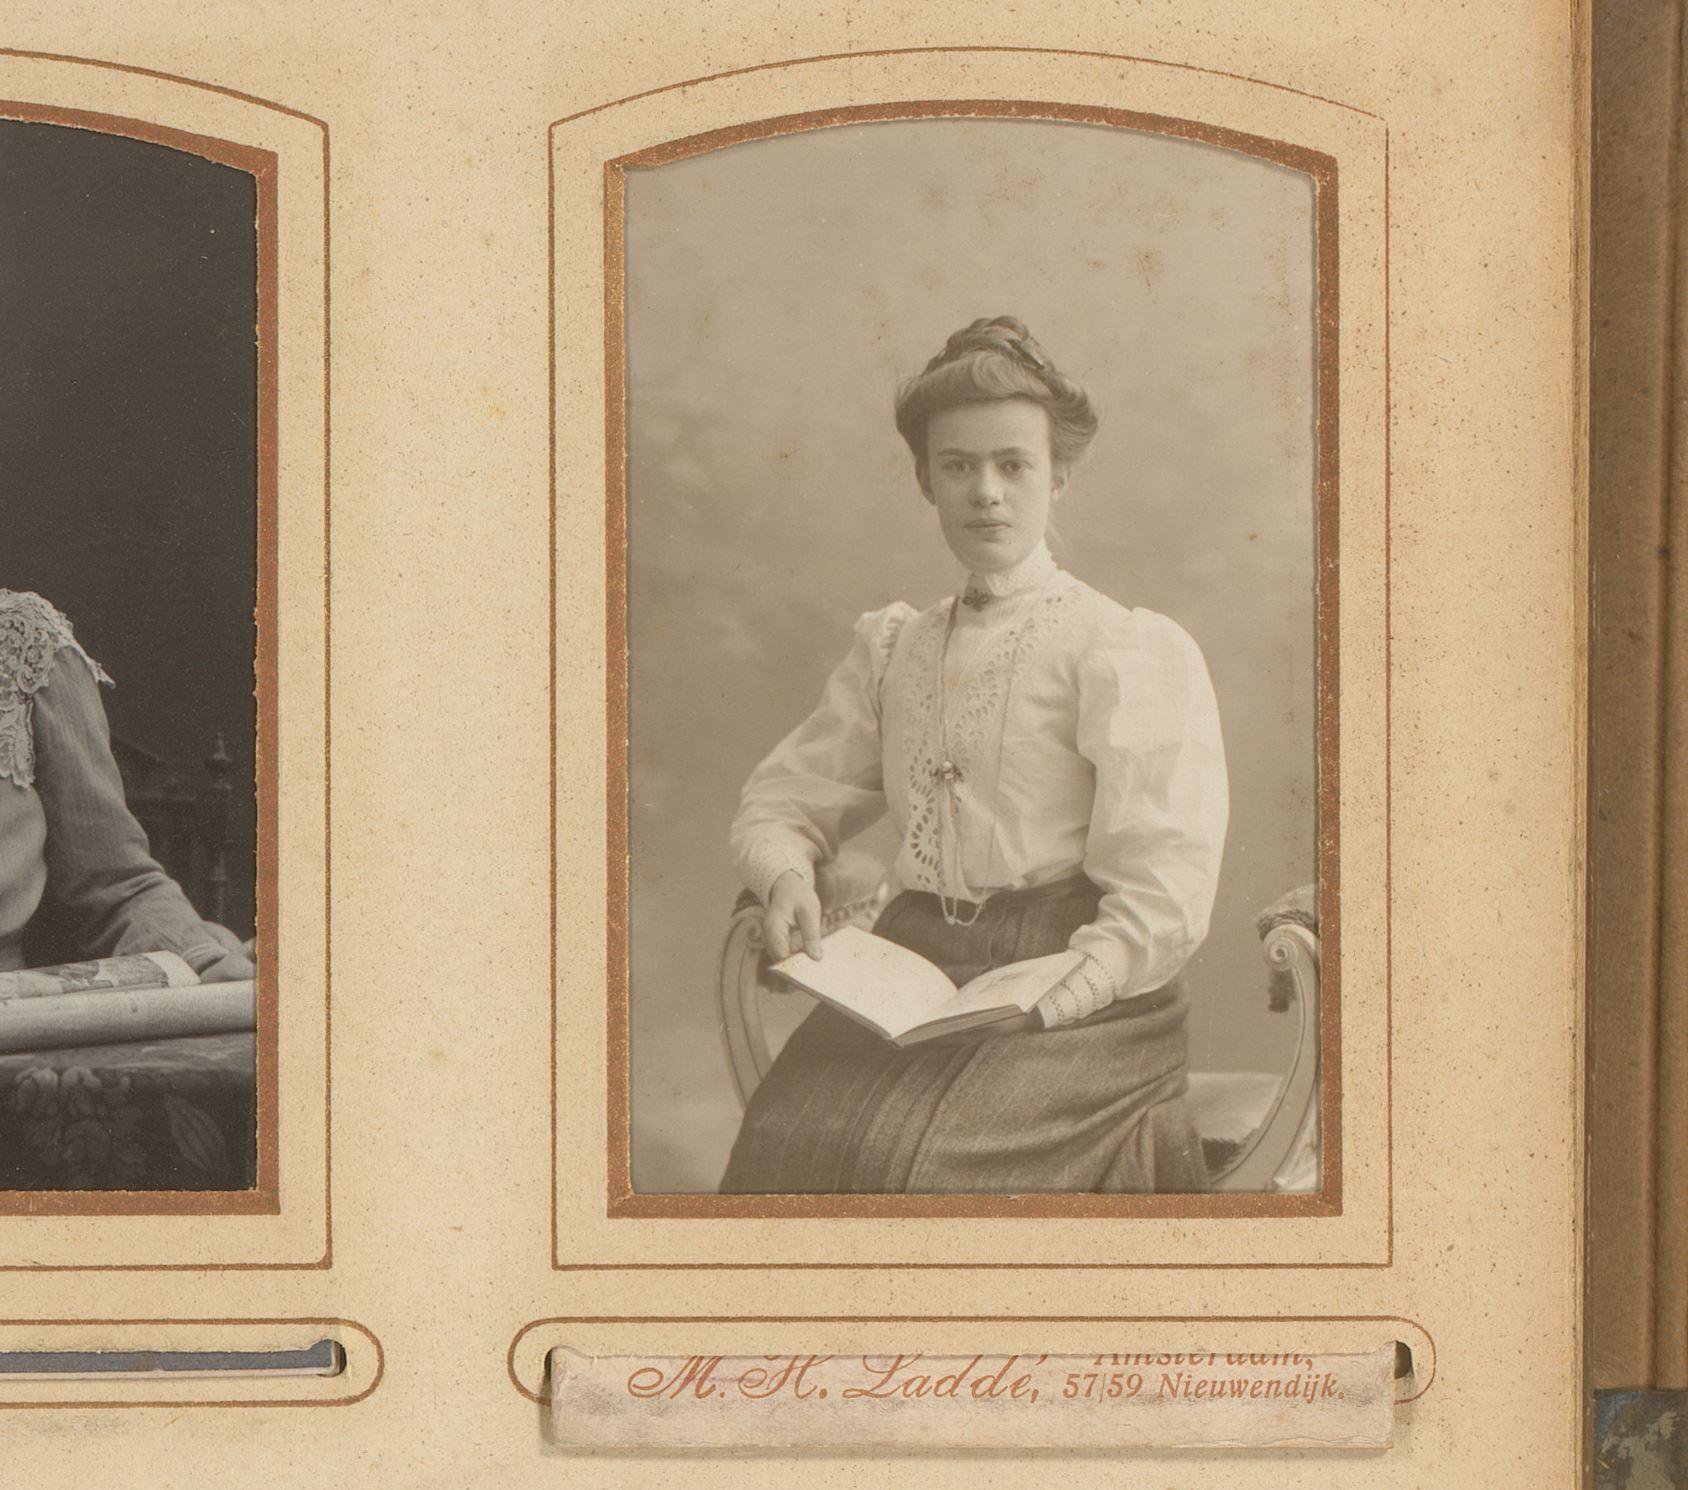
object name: photograph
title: Portret van een zittende vrouw met boek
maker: machiel hendricus laddé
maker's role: fotograaf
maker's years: 1866-1932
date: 1892-1906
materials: cardboard, photographic support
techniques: collodion silver print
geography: amsterdam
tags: historical persons - bb - woman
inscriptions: inscription: ‘M.H. Laddé/ Amsterdam/ 57/59 Nieuwendijk’